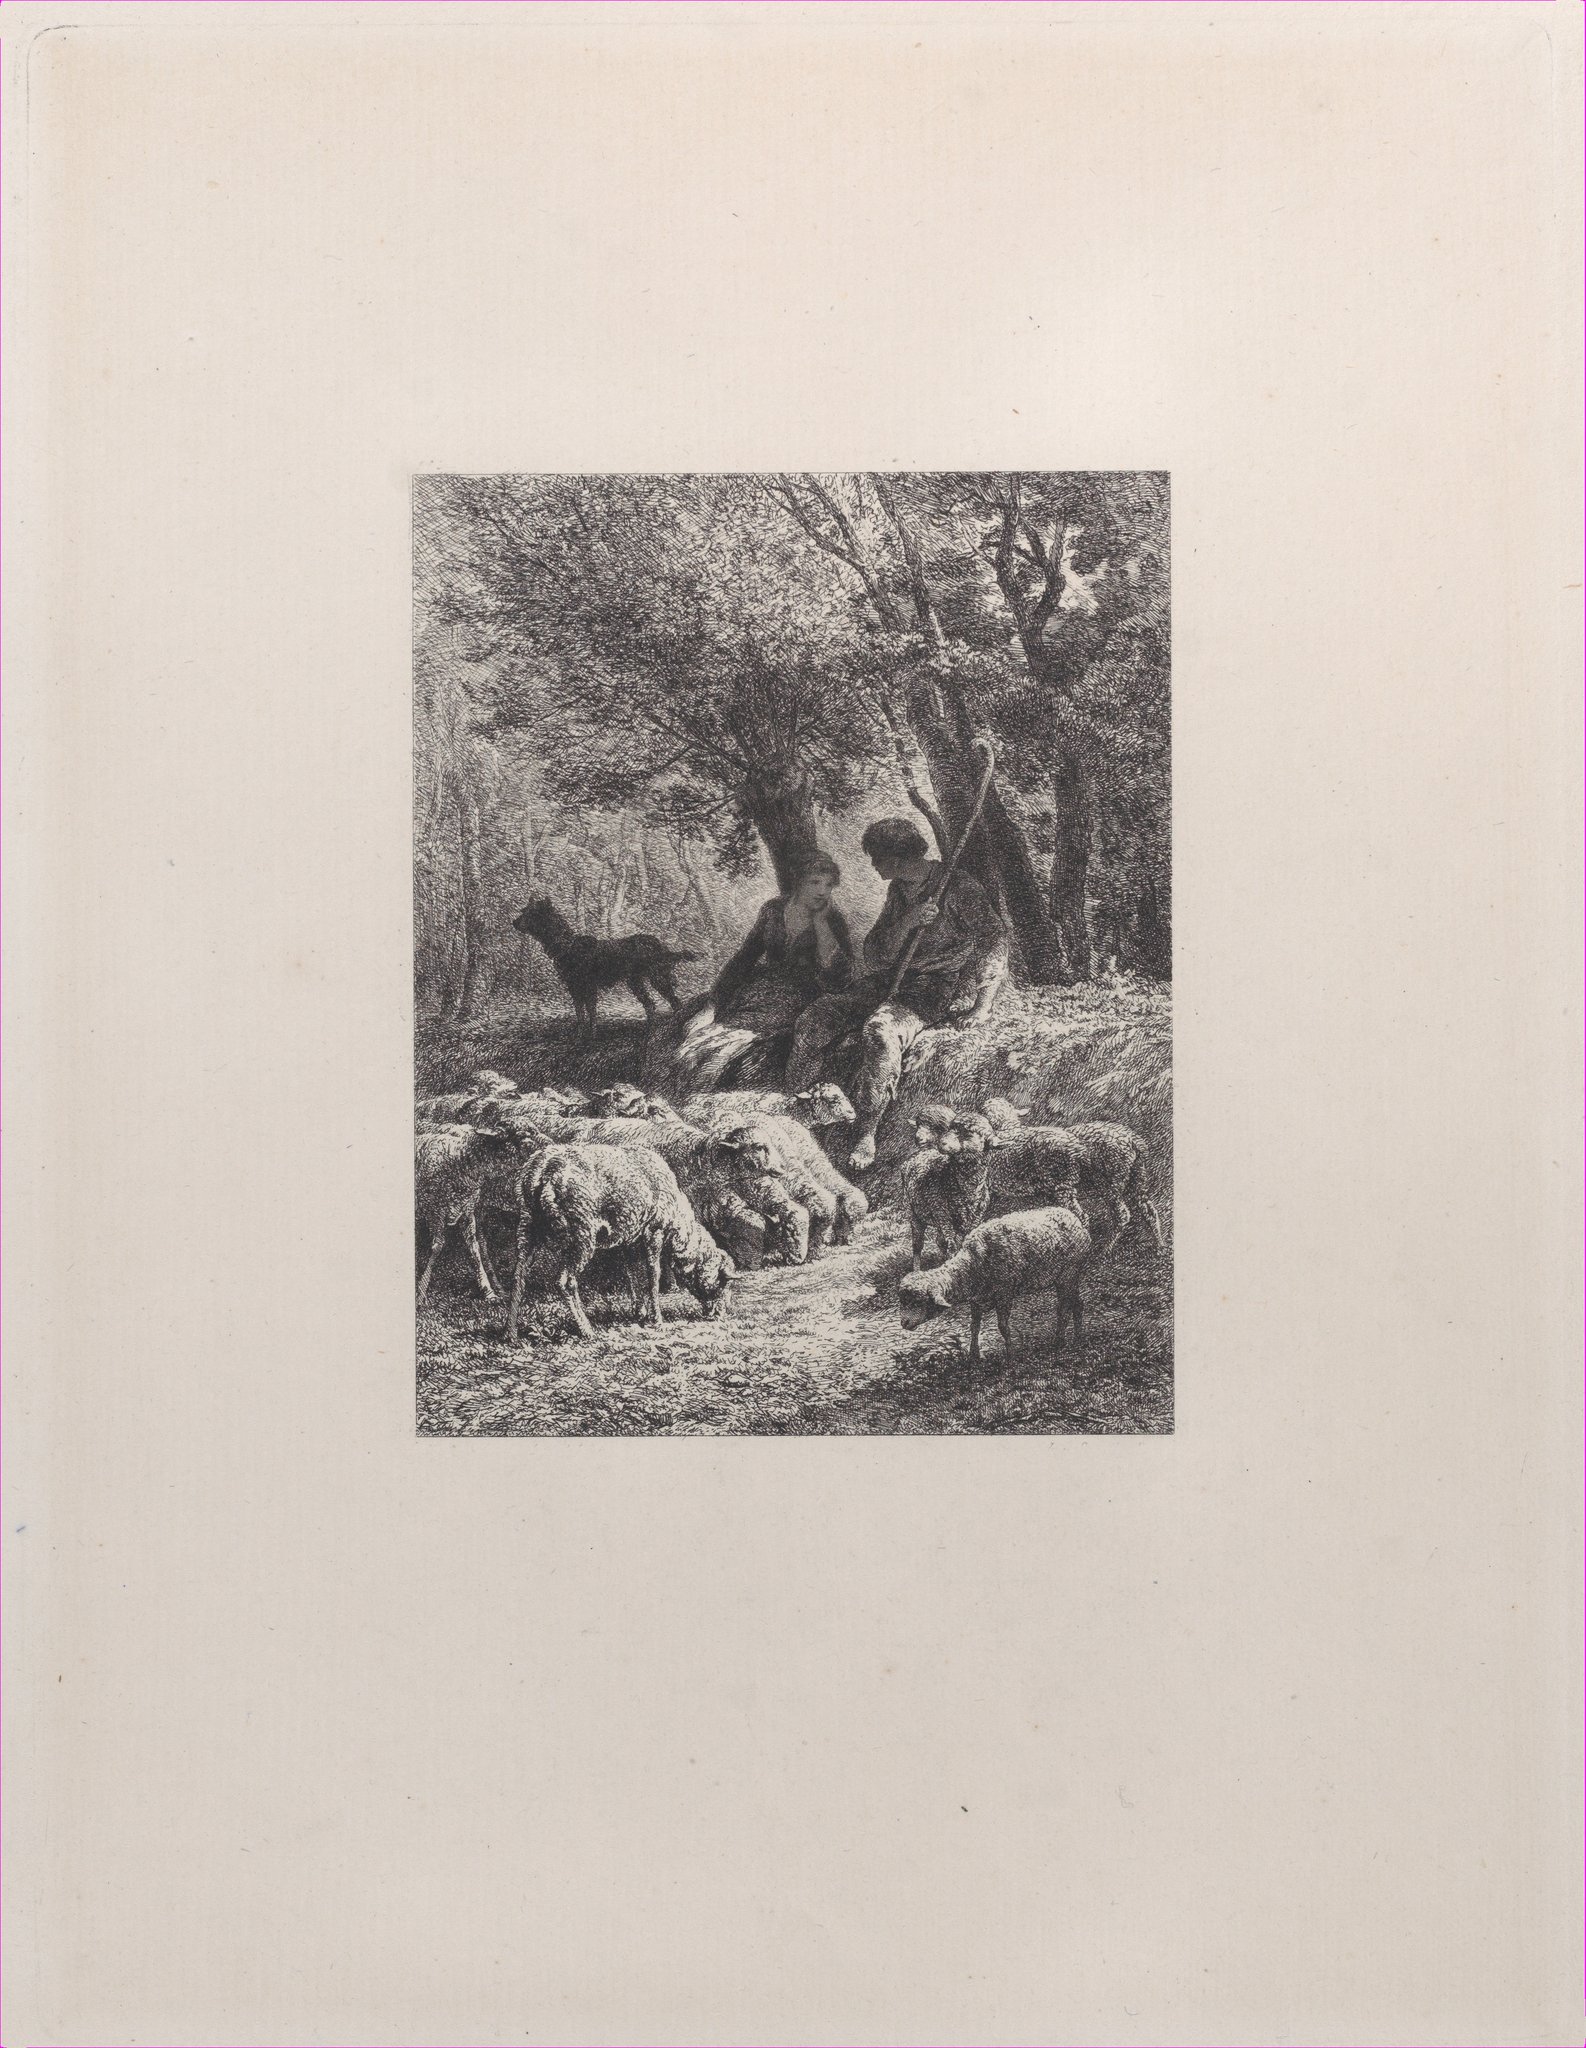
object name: print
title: Pastoral Scene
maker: charles émile jacque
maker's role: artist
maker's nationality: french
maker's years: 1813-1894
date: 1864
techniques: etching